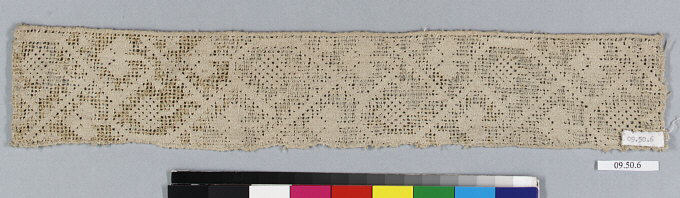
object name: fragment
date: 1501-1700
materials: linen, silk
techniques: embroidery